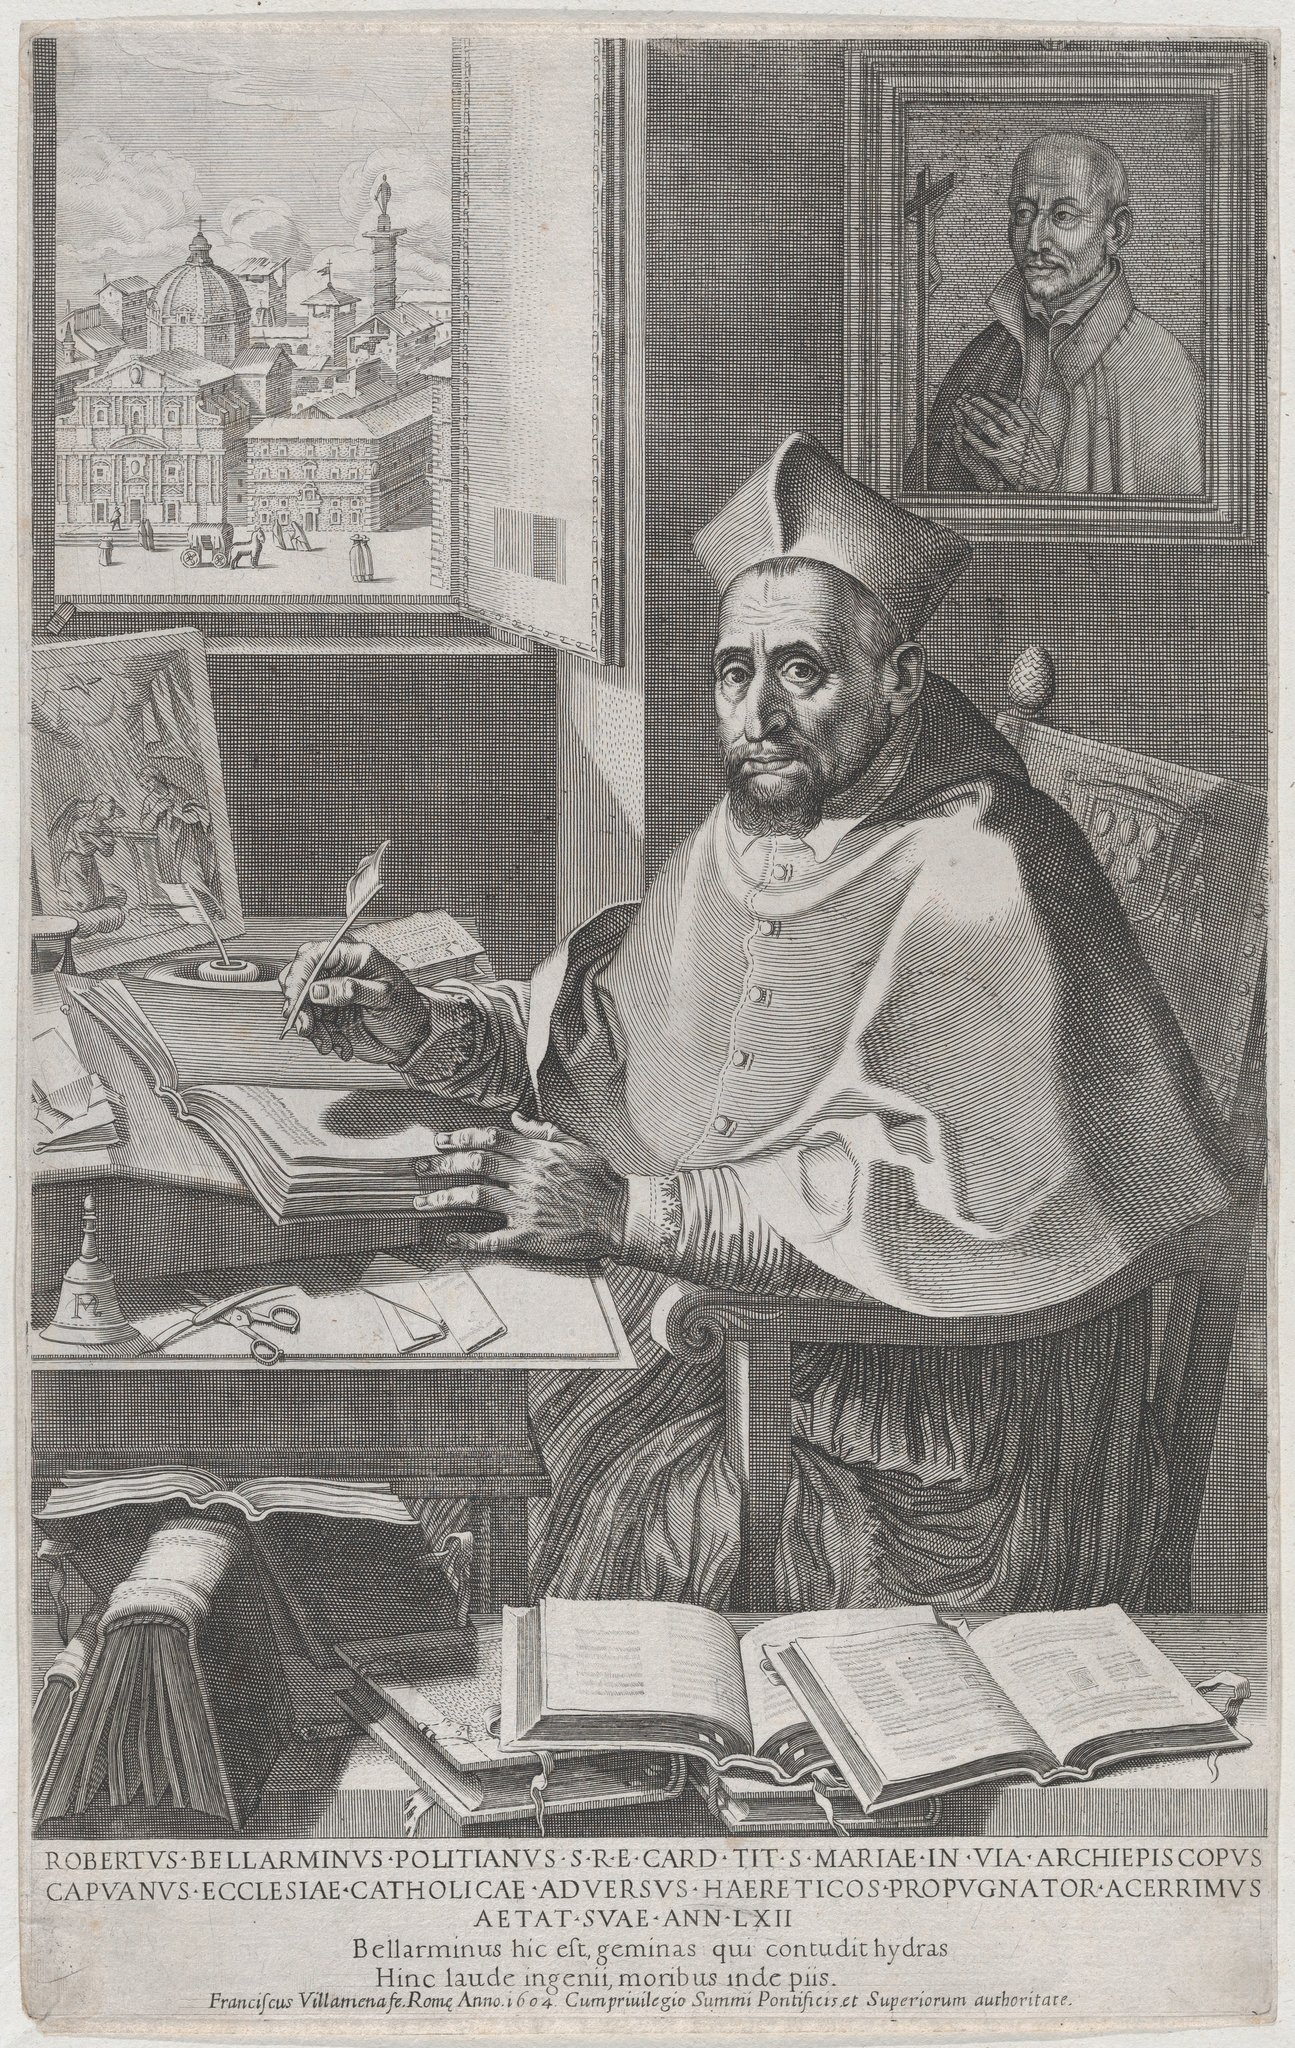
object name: print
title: Cardinal Roberto Bellarmino at his desk, writing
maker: francesco villamena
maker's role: artist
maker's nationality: italian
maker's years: 1565-1624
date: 1604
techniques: engraving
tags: men,writing,desks